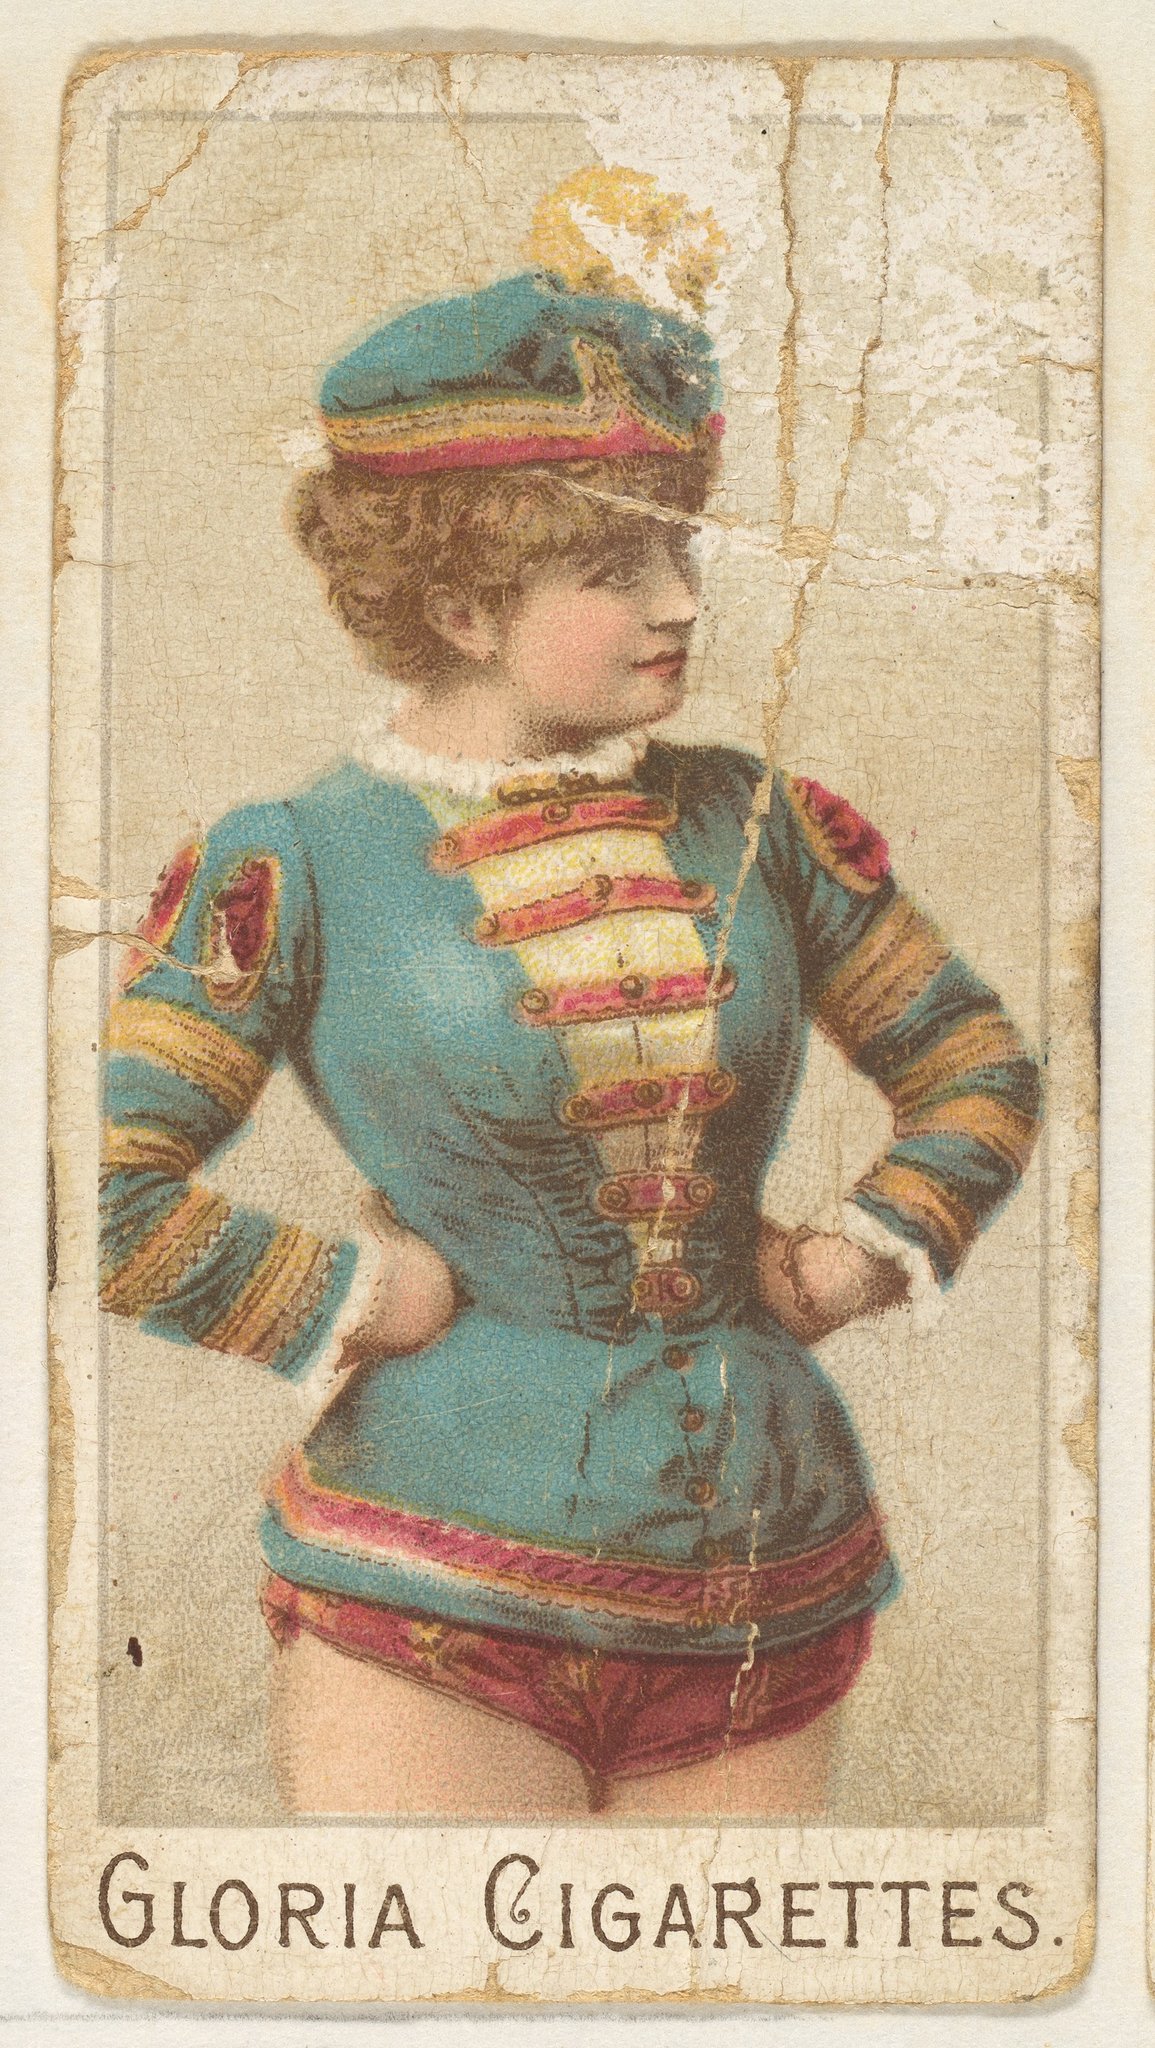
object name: print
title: From the series "Sports Girls" (C190), issued by the American Cigarette Company, Ltd., Montreal, to promote Gloria Cigarettes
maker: american cigarette company, ltd.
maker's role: publisher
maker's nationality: canadian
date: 1889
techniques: color lithograph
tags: women,athletes